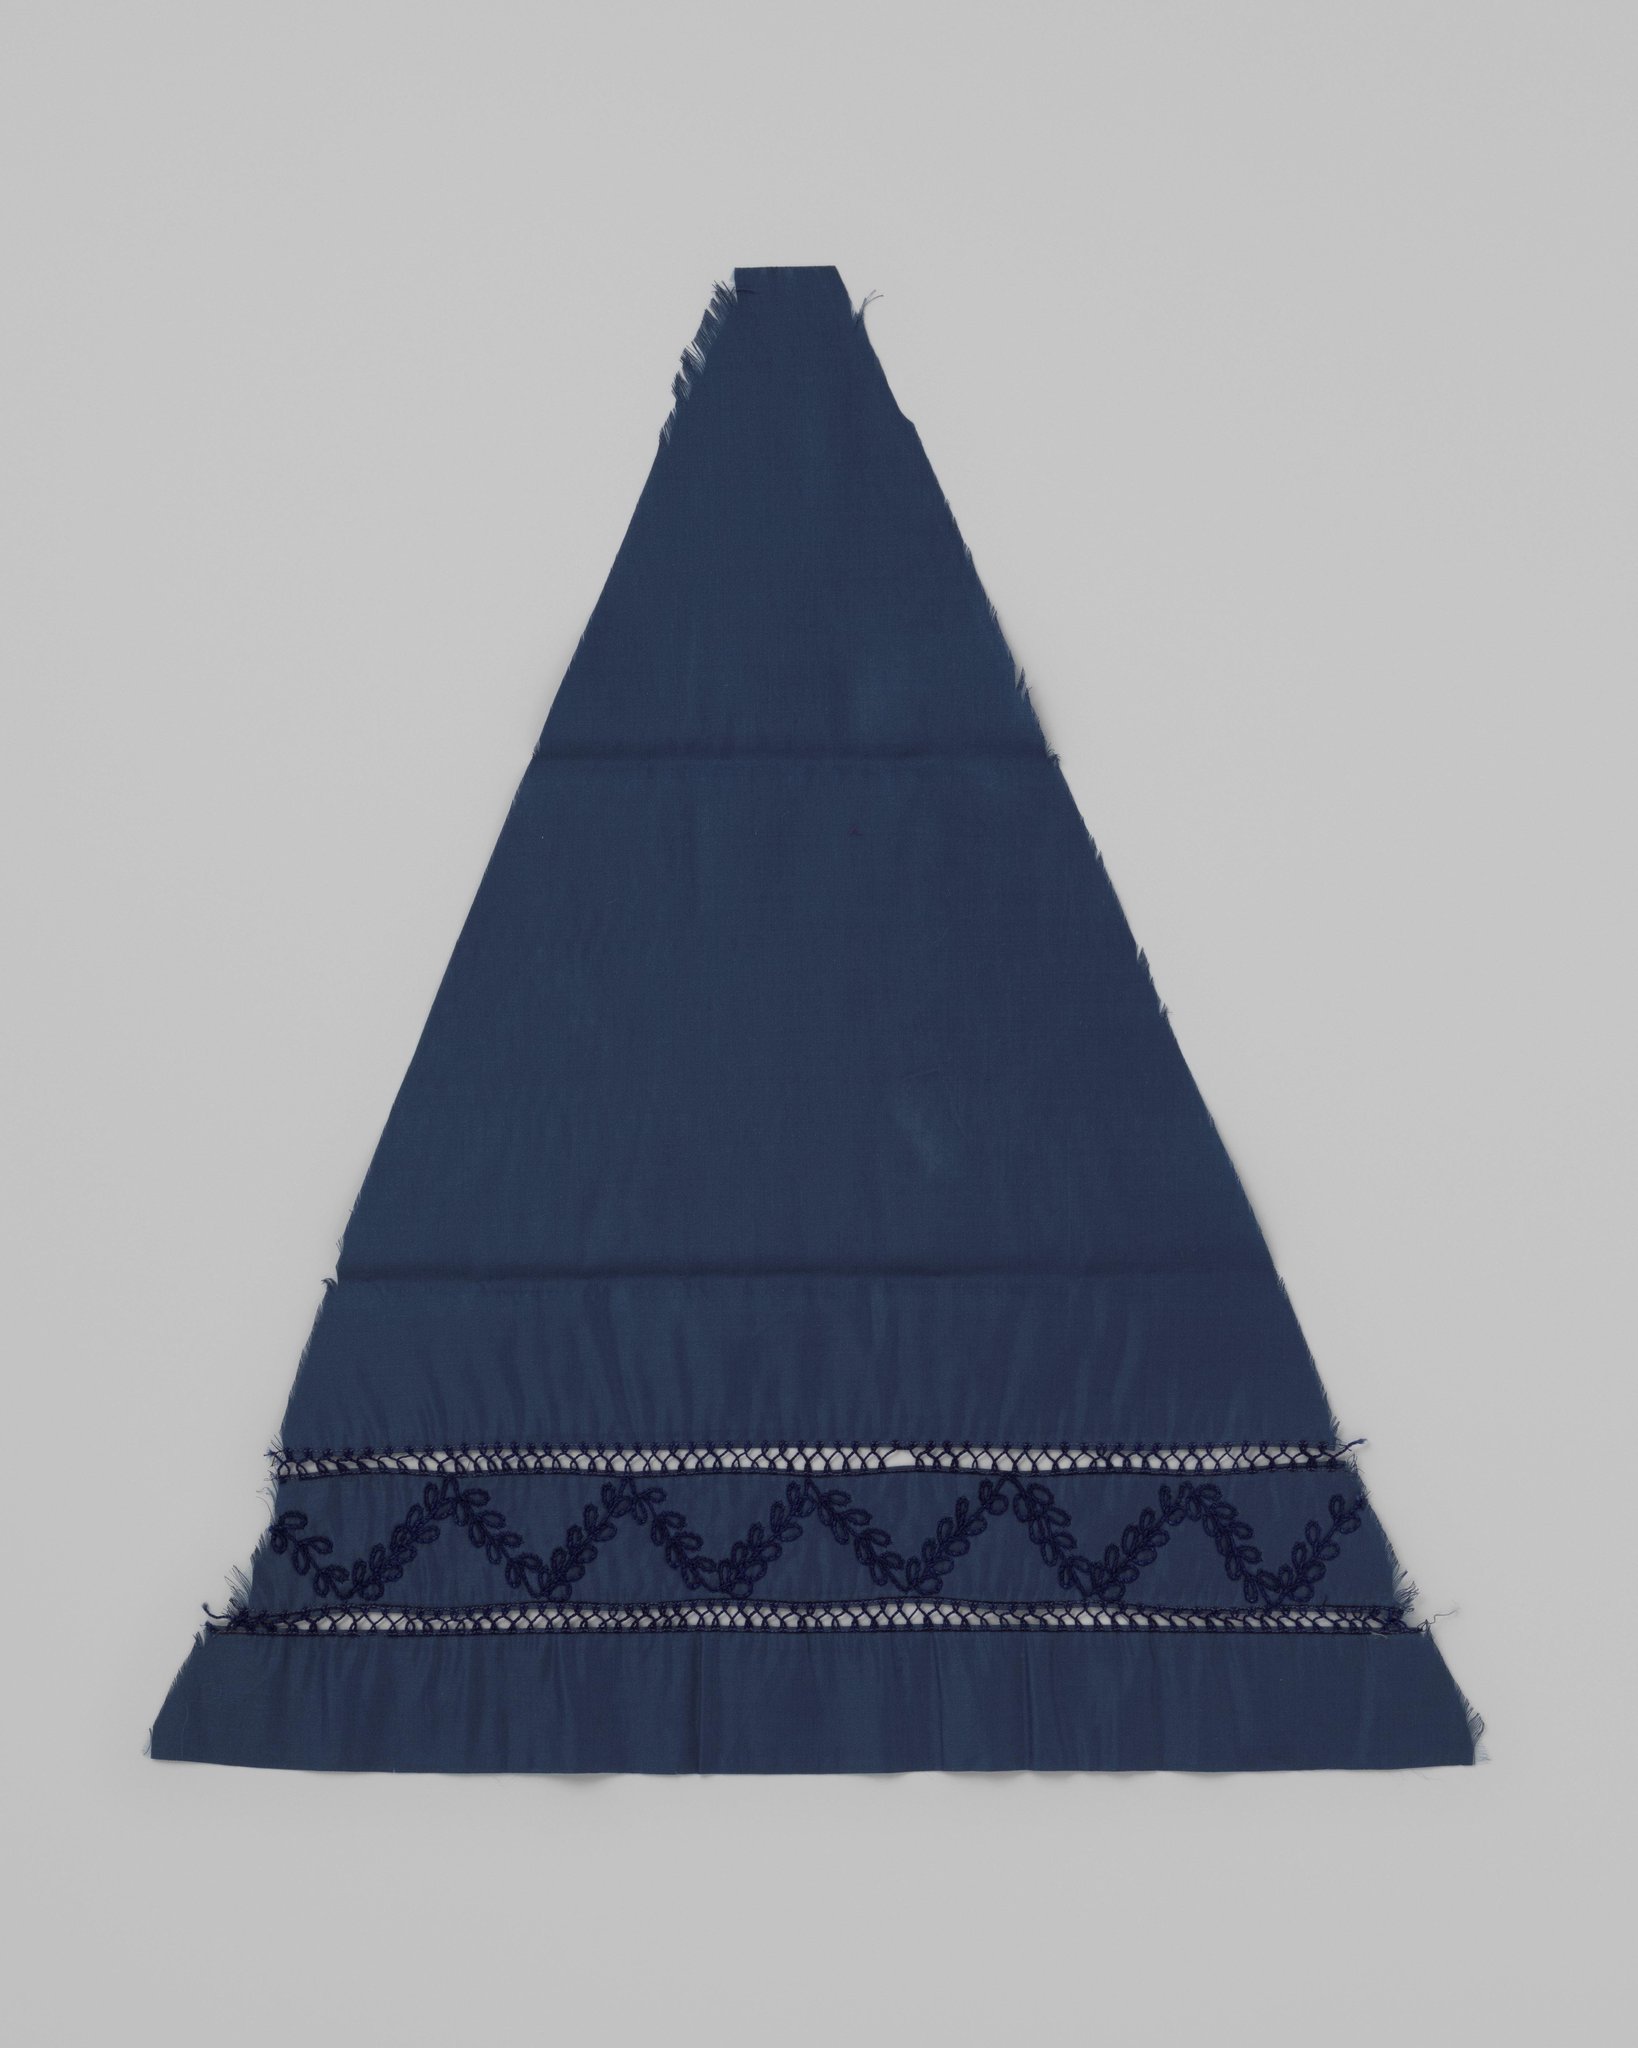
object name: parasoldek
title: Sector van een parasoldek van donkerblauwe katoen, versierd met borduurwerk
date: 1885-1900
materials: cotton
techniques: embroidered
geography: nijmegen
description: Sector van een parasoldek van donkerblauwe katoen, versierd met borduurwerk. Het borduurwerk bestaat uit twee rijen stiksteken doorgeregen met een flanelsteek, waartussen een slingerende bladrank. Aan het dek is een etiket bevestigd met een metalen klem.